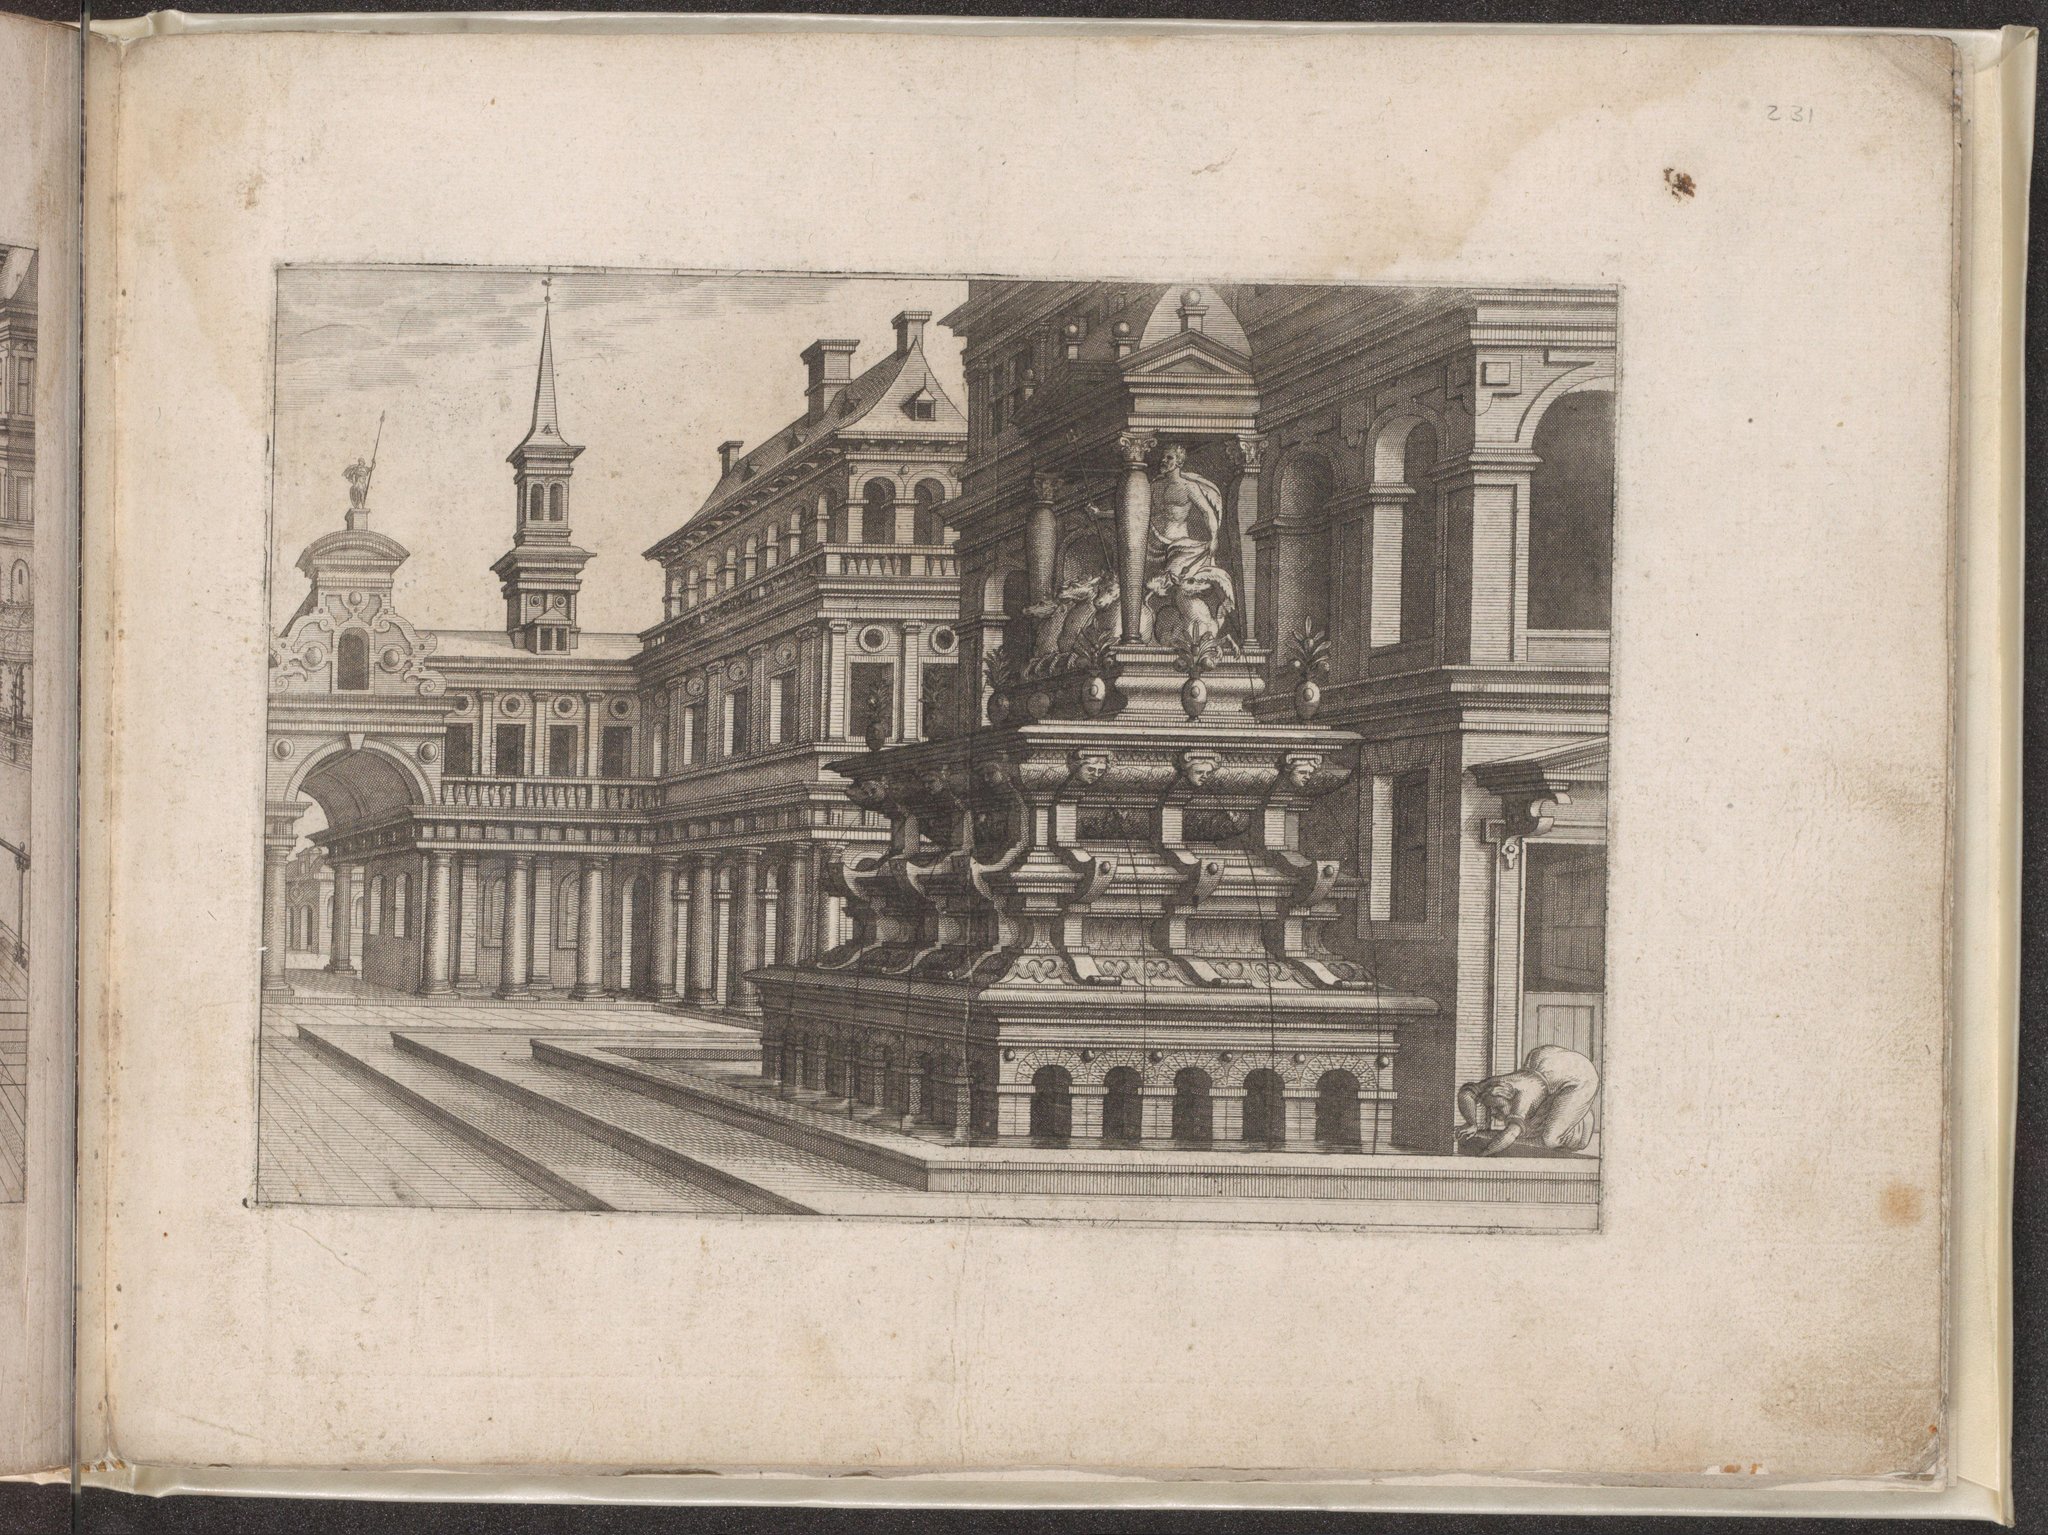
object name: print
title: Artis Perspectivae (...)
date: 1568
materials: paper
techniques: etching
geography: antwerp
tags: (story of) neptune (poseidon), palace, piece of sculpture, reproduction of a piece of sculpture, ornamental fountain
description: Stadsplein met twee paleizen. Rechts een fontein bekroond met Neptunus in zijn wagen onder een baldakijn. Deze prent maakt deel uit van een album.